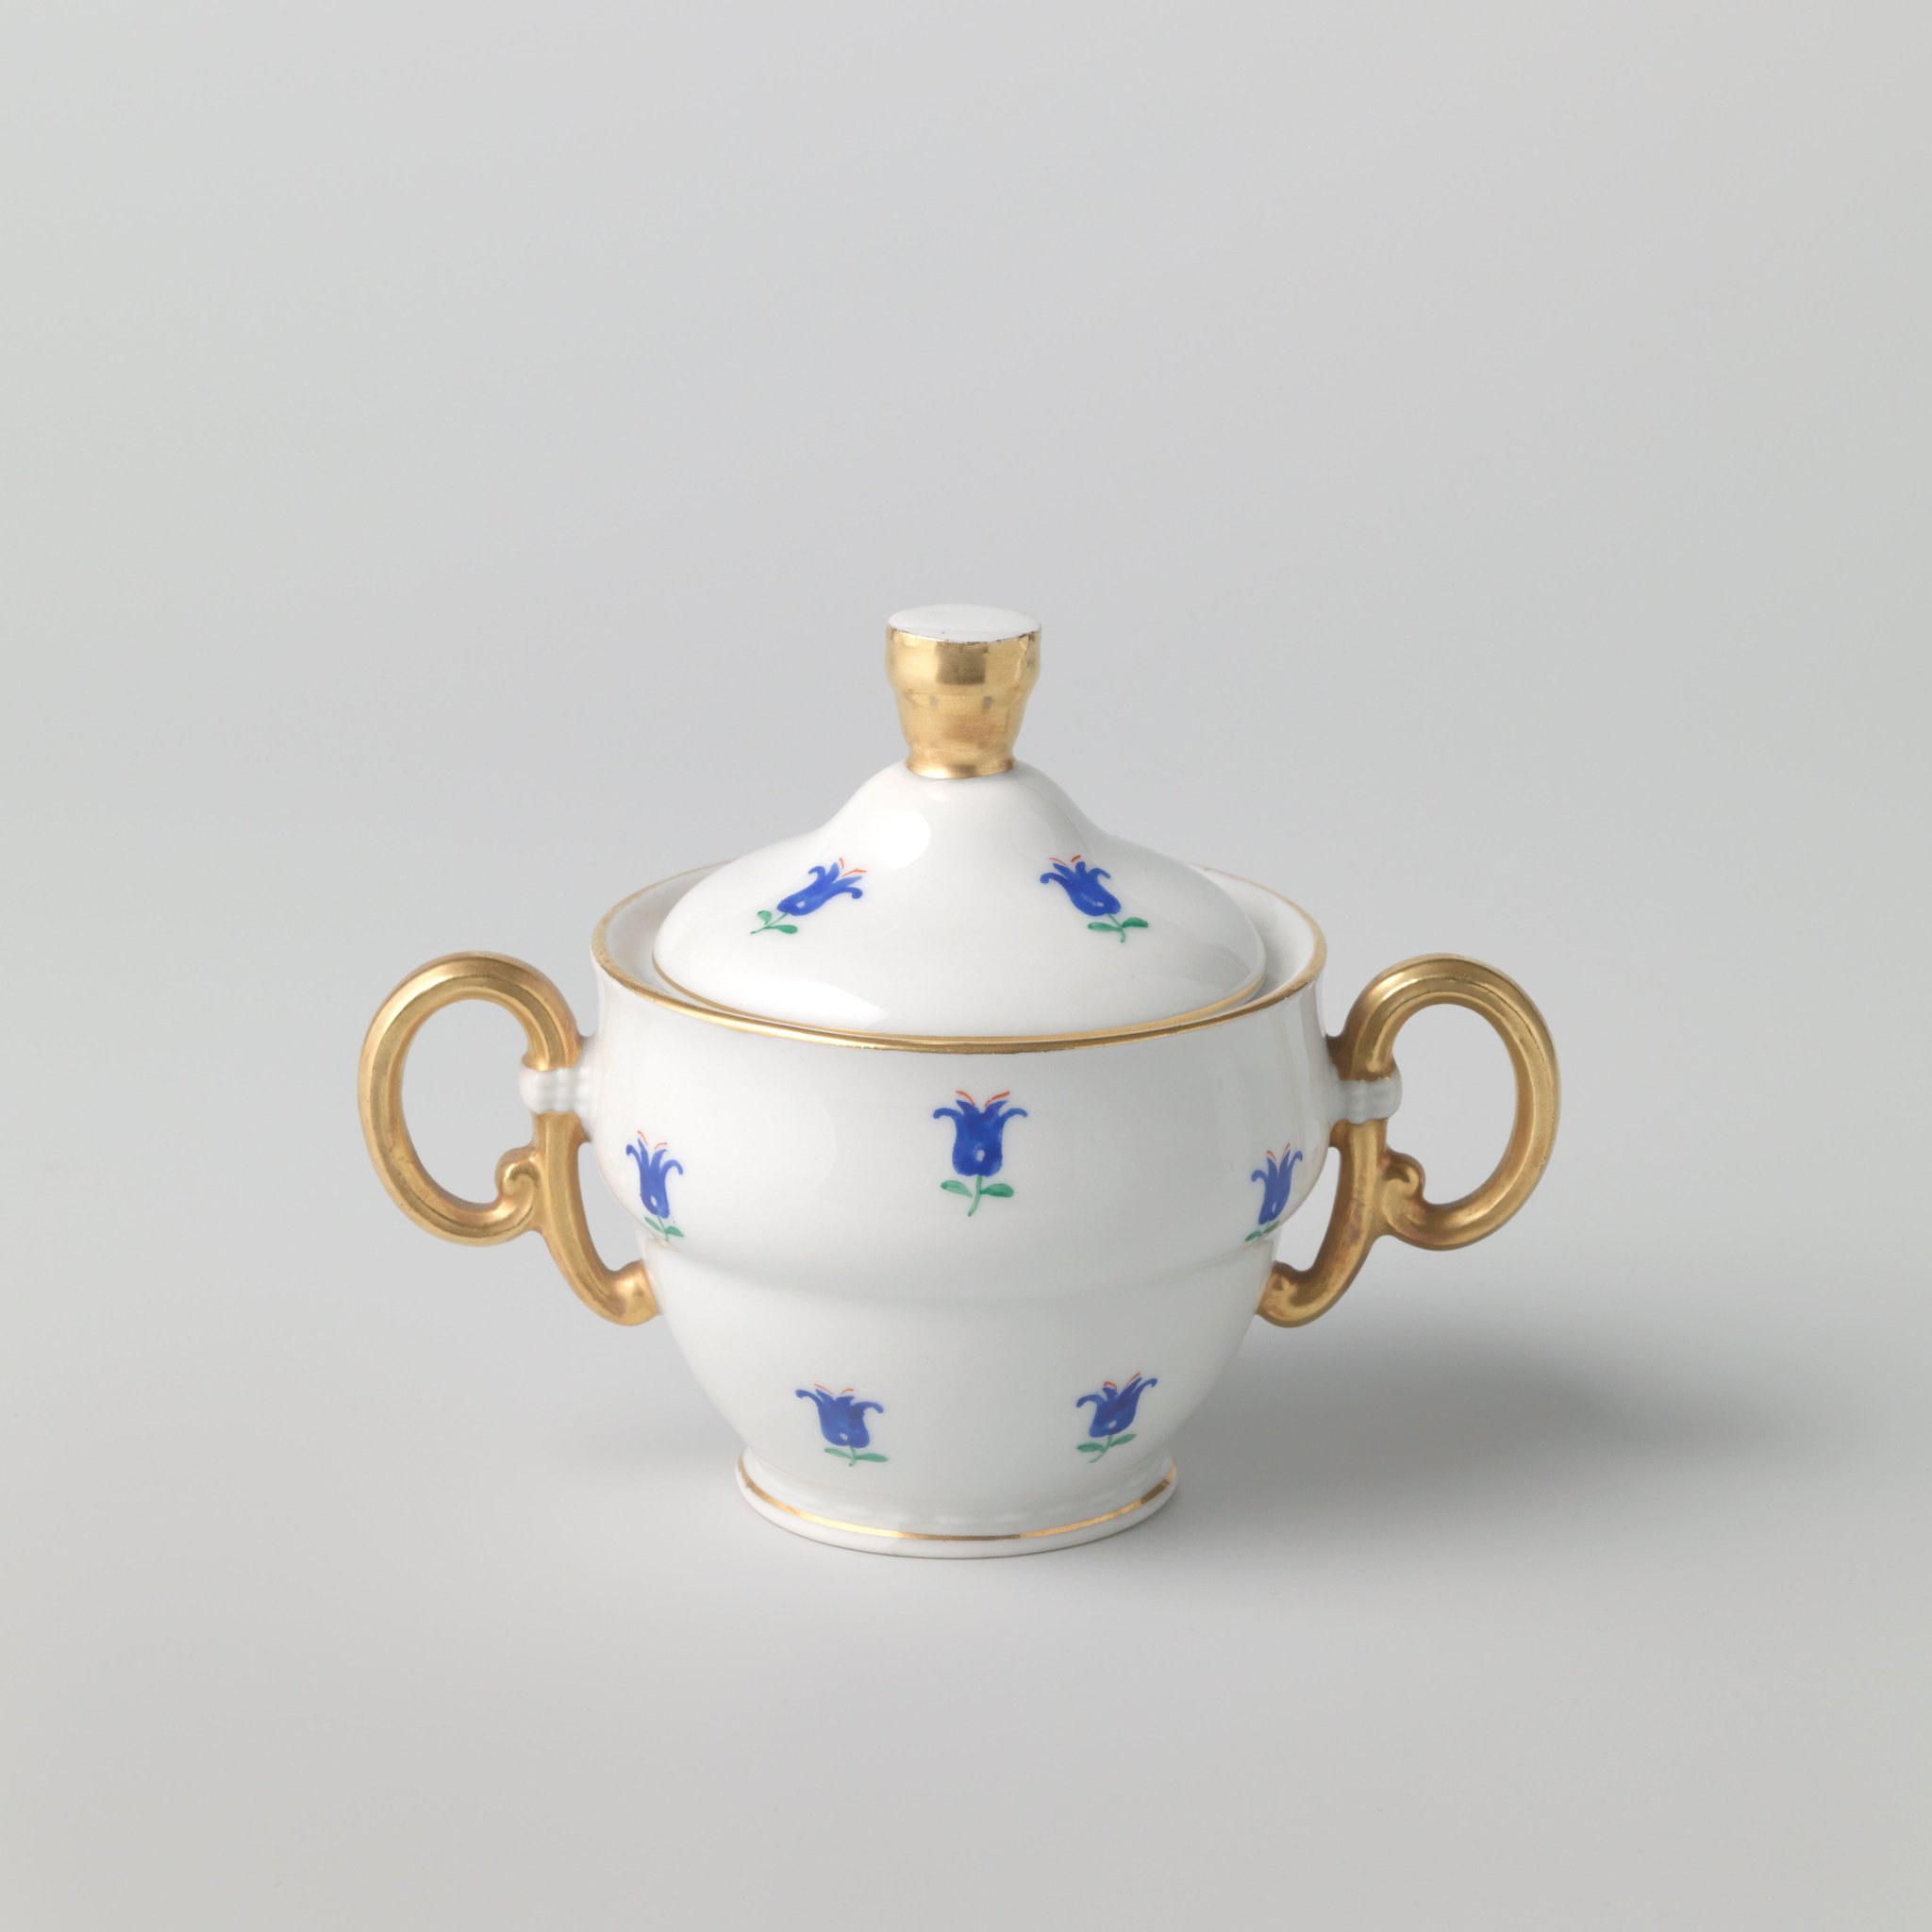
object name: coffee service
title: Sugar bowl with flowers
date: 1935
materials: glaze, gold, paint, porcelain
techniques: firing, forming, gilding, turning, vitrification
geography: karlovy vary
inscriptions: mark: ‘gekruiste hamers met kroon/ EPIAG PIRKENHAMMER CECHOSLOW/ 5857’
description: Suikerpot van porselein op iets spreidende voet met een licht uitlopende wand die net boven de helft verdikt en uitloopt, twee P-vormige oren. Beschilderd op het glazuur in blauw, rood, groen en goud. De buitenwand met blauwe bloemen en gouden oren. Gouden lijn op de voet en de rand. Deksel met dezelfde decoratie en conische, gouden dekselknop. Gemerkt op de onderzijde met de gekruiste hamers met kroon, de tekst 'EPIAG PIRKENHAMMER CECHOSLOW' en het nummer 5857.